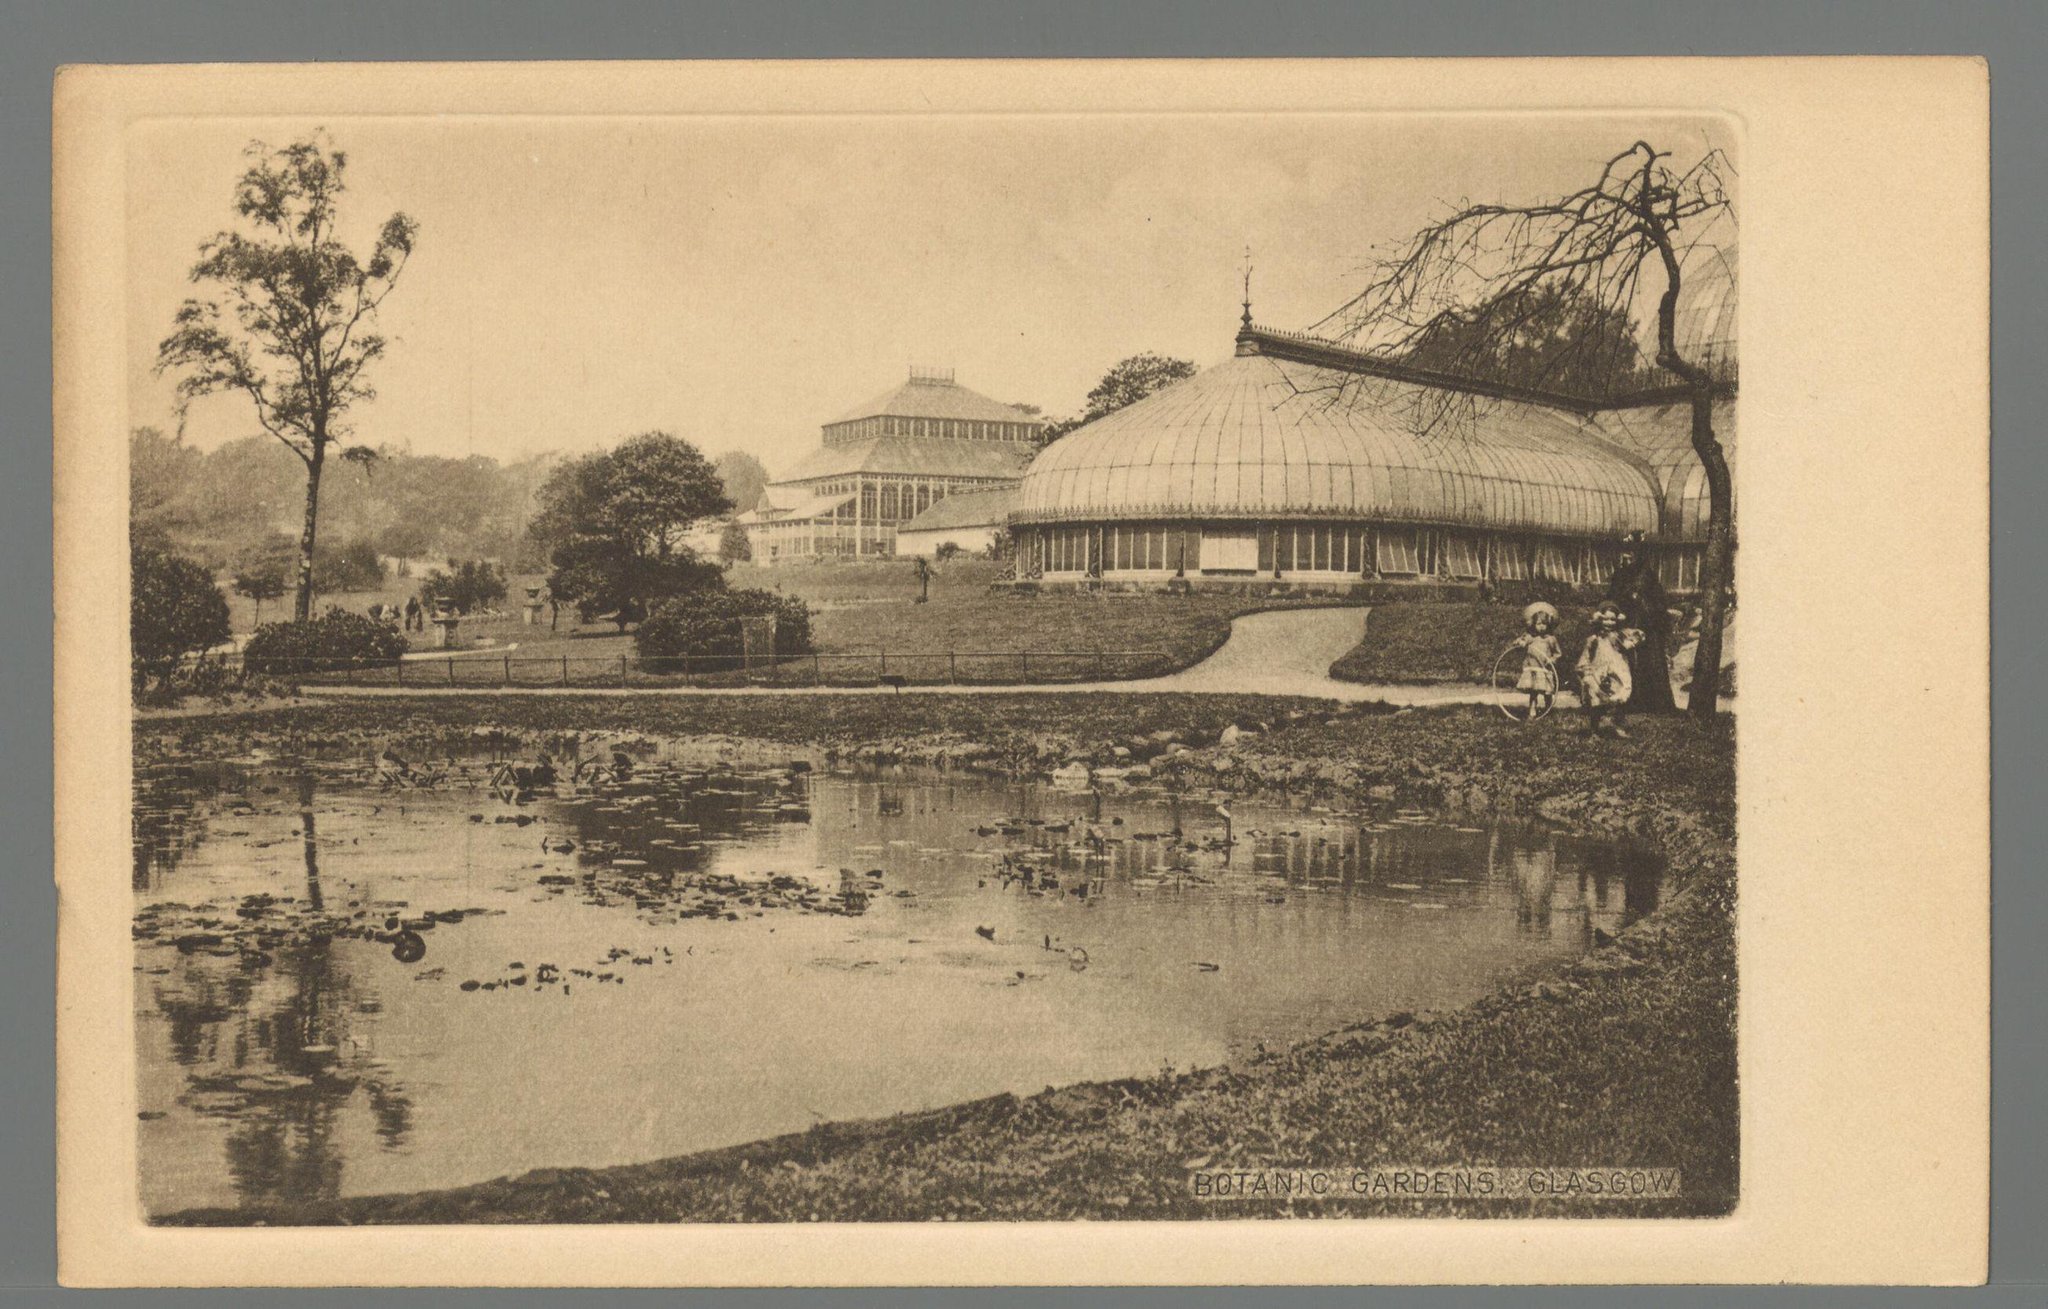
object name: photomechanical print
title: Botanic Gardens, Glasgow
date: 1894-1905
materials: cardboard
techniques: photoaquatint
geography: glasgow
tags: botanic garden, 'hortus botanicus', pond, glasgow